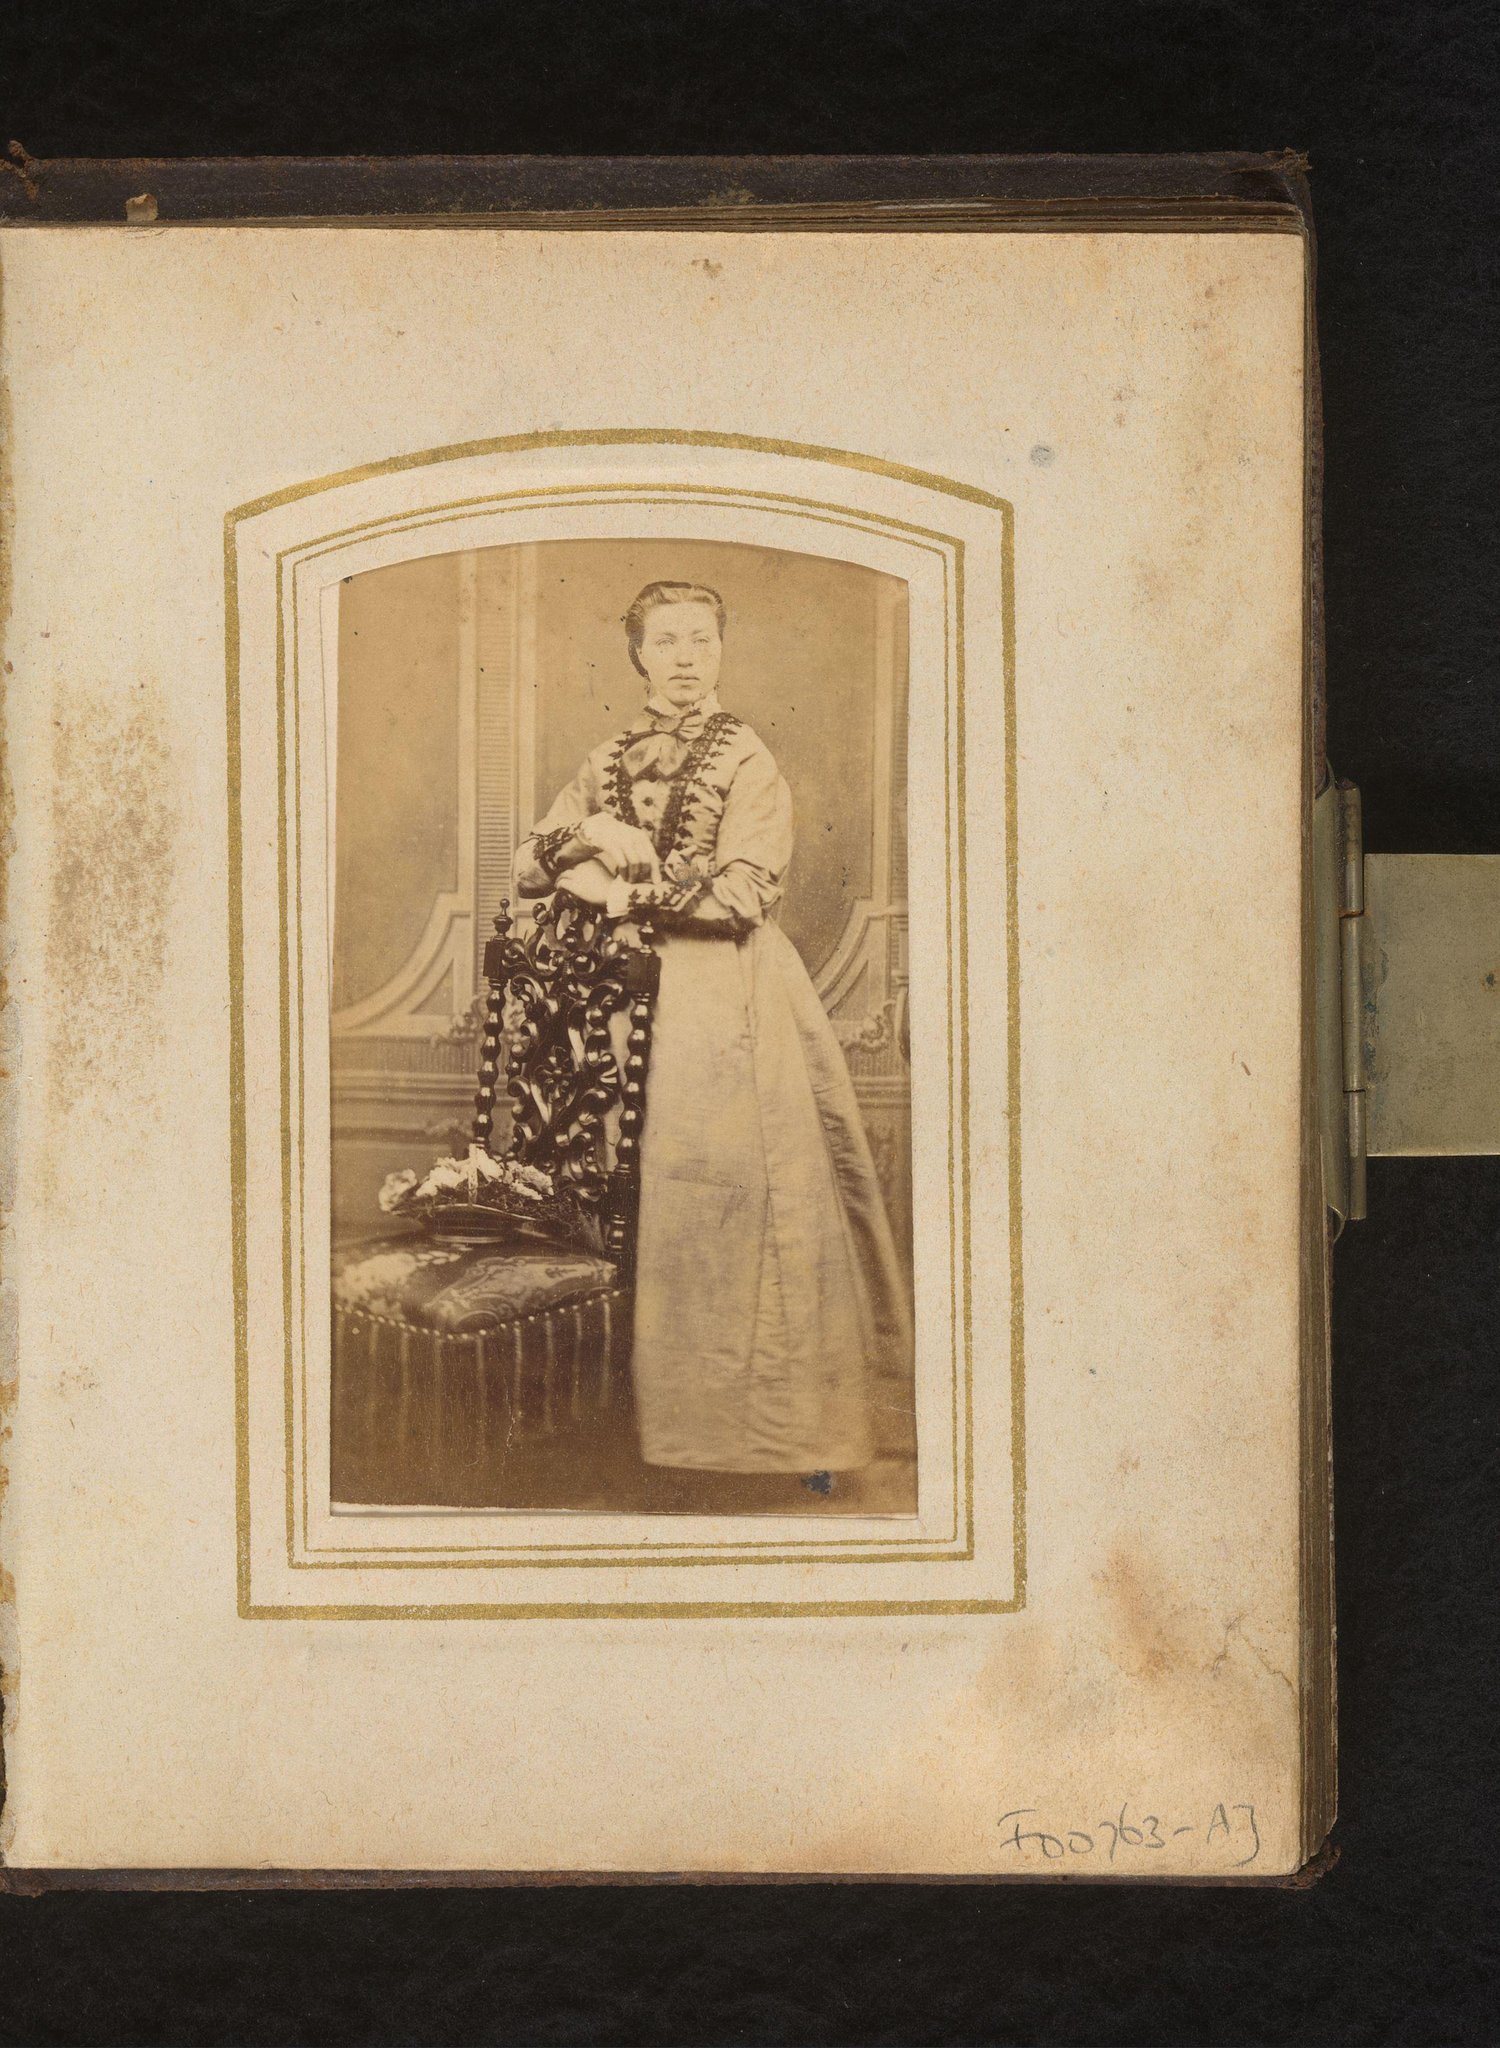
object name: album leaf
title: Portret van een vrouw, staand bij een stoel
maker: coenraad cornelis roskam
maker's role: fotograaf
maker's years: 1829-1892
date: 1870-1892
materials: cardboard, photographic support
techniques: albumen print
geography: amsterdam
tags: historical persons - bb - woman, standing figure - aa - female human figure, chair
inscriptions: inscription: ‘PHOTOGR. ATELIER/ C. C. ROSKAM/ Utrechtschestraat/ tusschen de Keizersgracht en Kerkstraat/ Z. 855./ AMSTERDAM.’